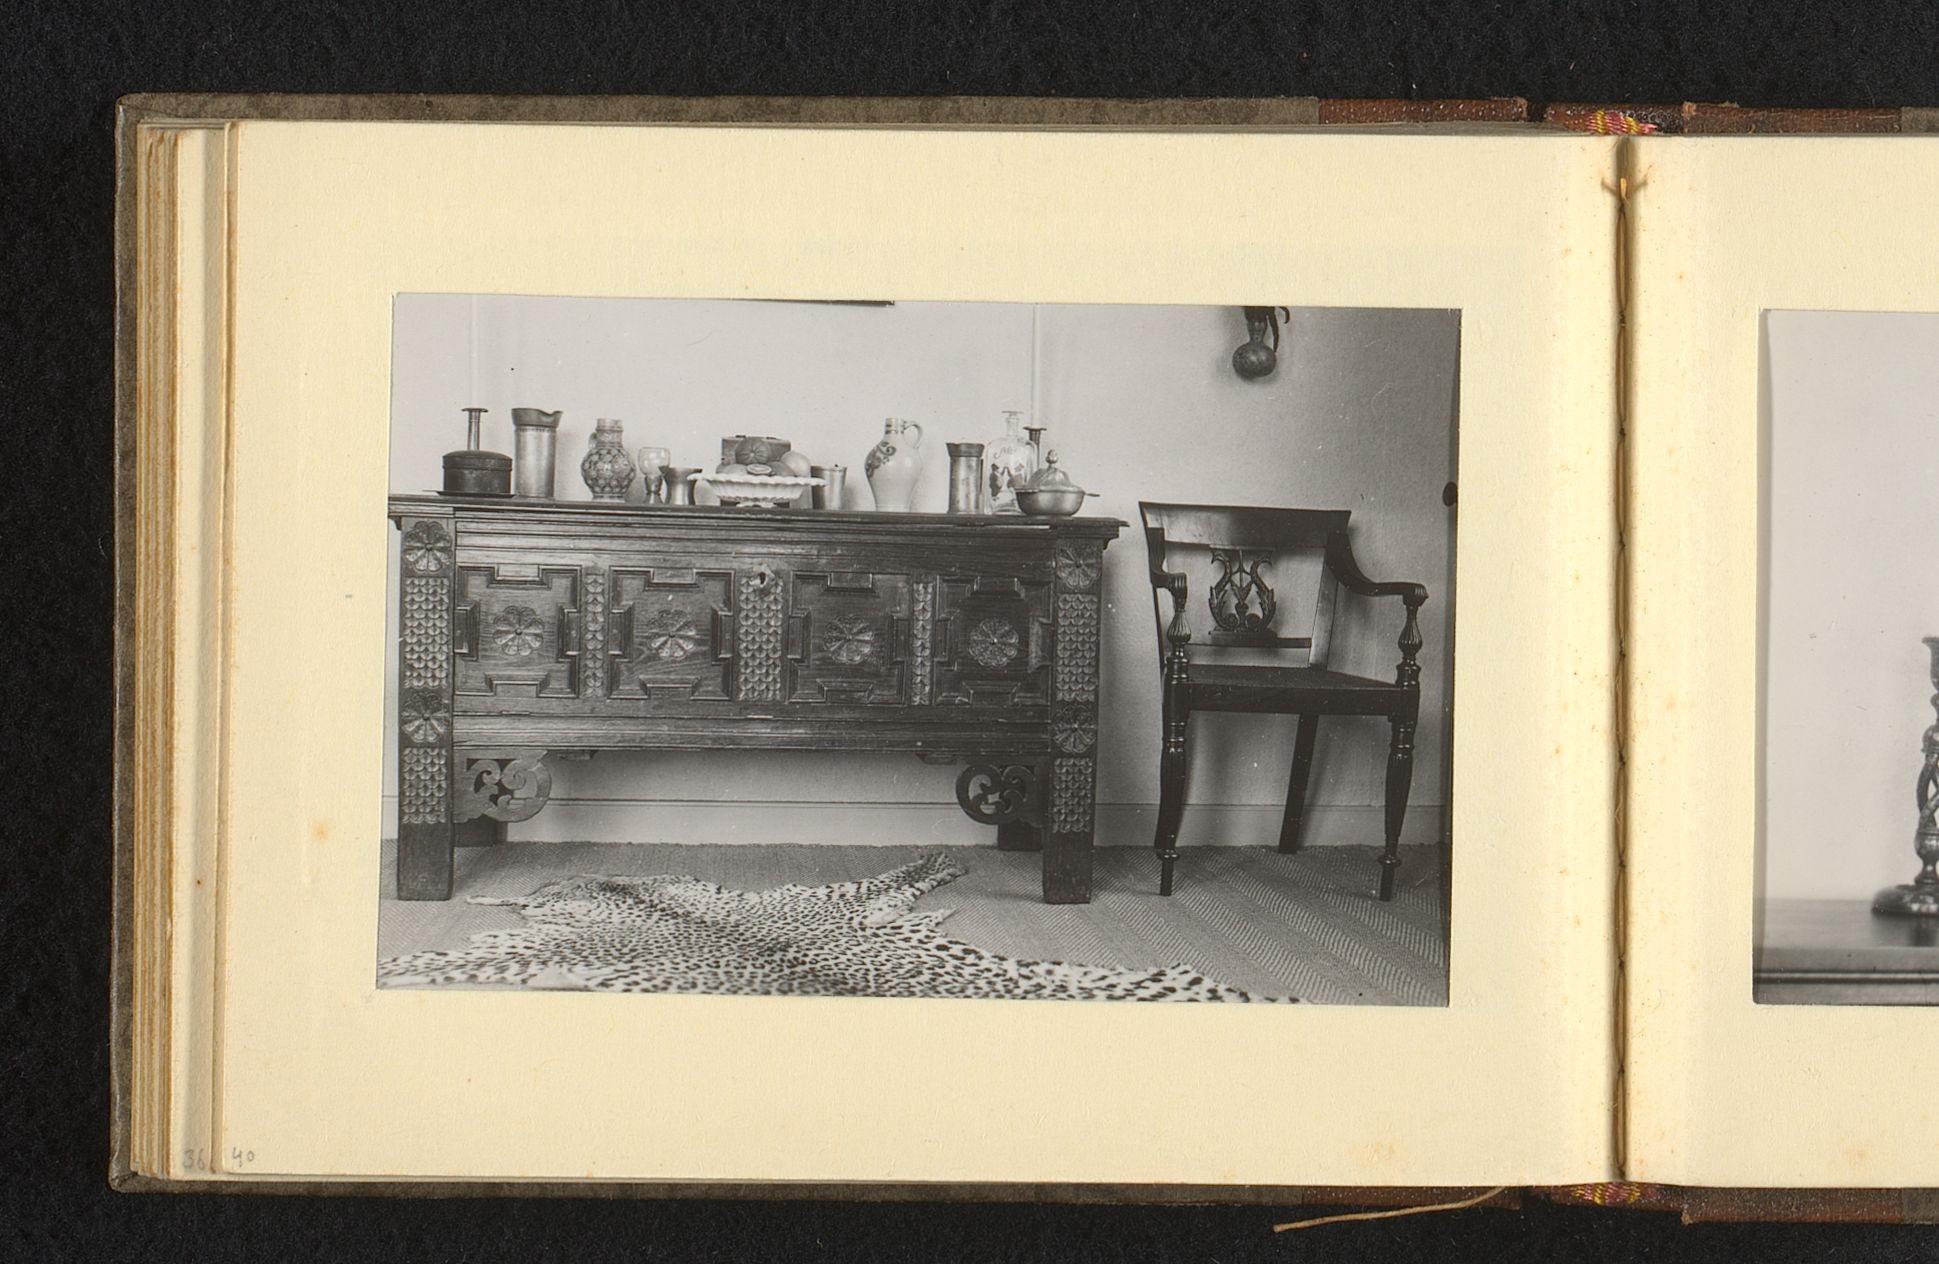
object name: album leaf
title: Interieur met dressoir, pantervel en stoel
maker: norbert van den berg (1901-1972)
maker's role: amateurfotograaf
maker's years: 1901-1972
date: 1935-1950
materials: paper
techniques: gelatin silver print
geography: netherlands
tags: shelves, rack, sideboard, beasts of prey, predatory animals: panther, interior of the house